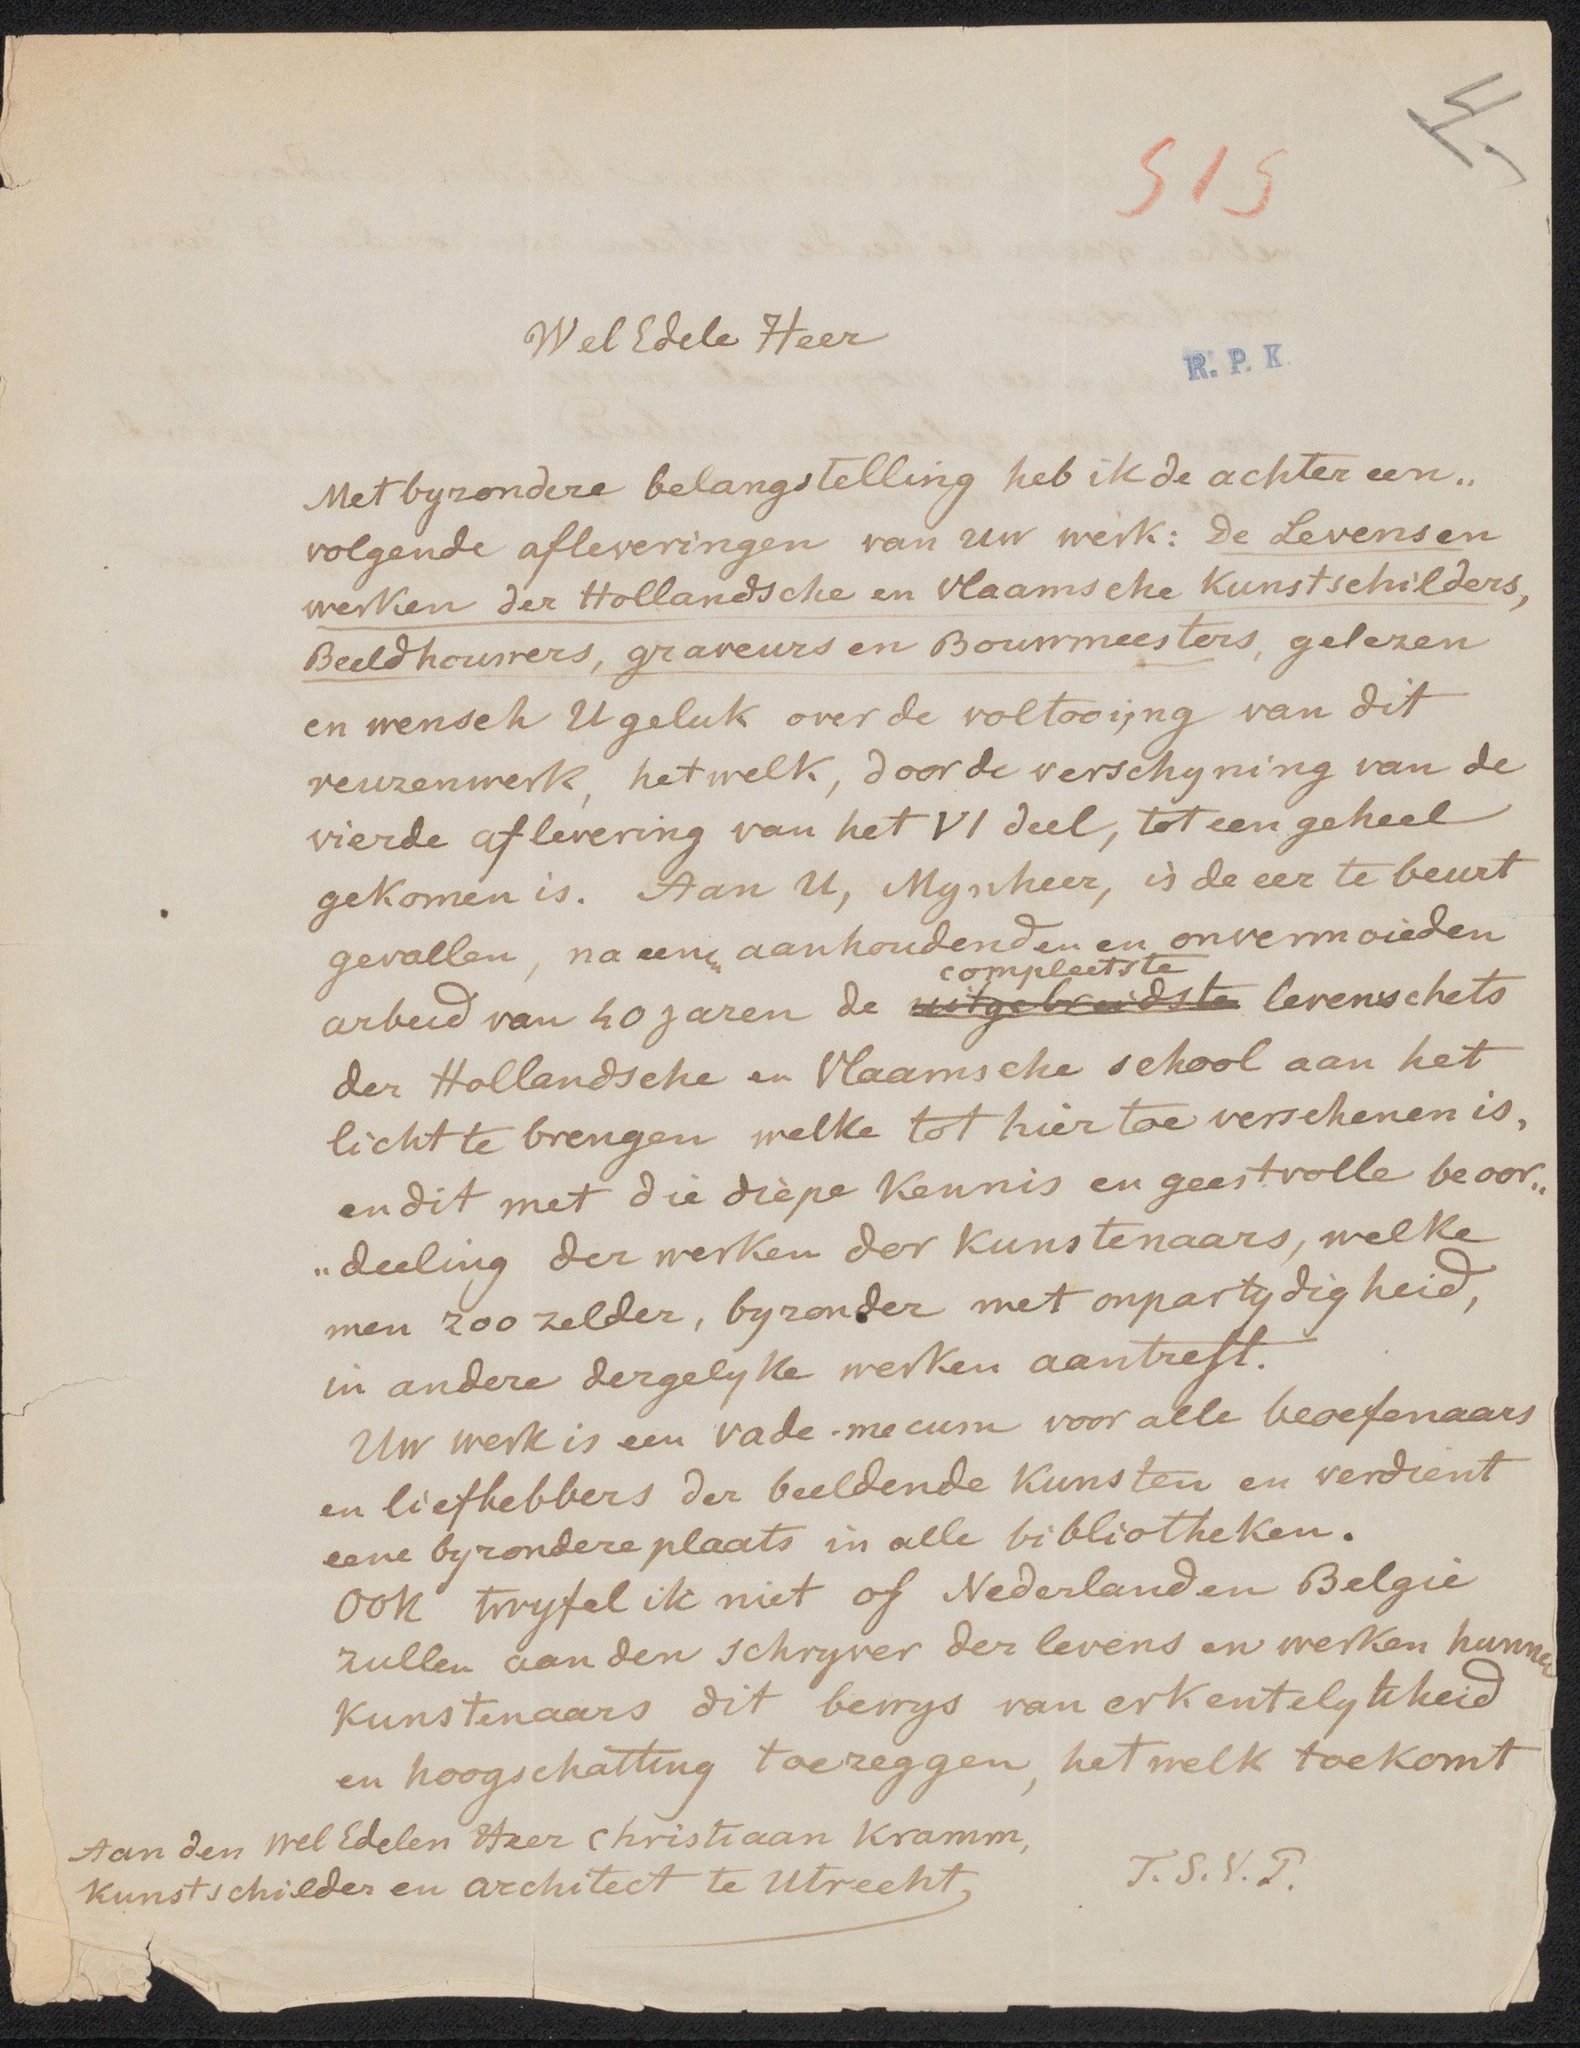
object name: letter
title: Brief aan Christiaan Kramm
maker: alexander schaepkens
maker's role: draughtsman, print maker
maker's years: 1815-1899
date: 1863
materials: ink, paper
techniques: pen, writing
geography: maastricht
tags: utrecht, print maker, draughtsman, christiaan kramm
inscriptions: collector's mark: Lugt 2233